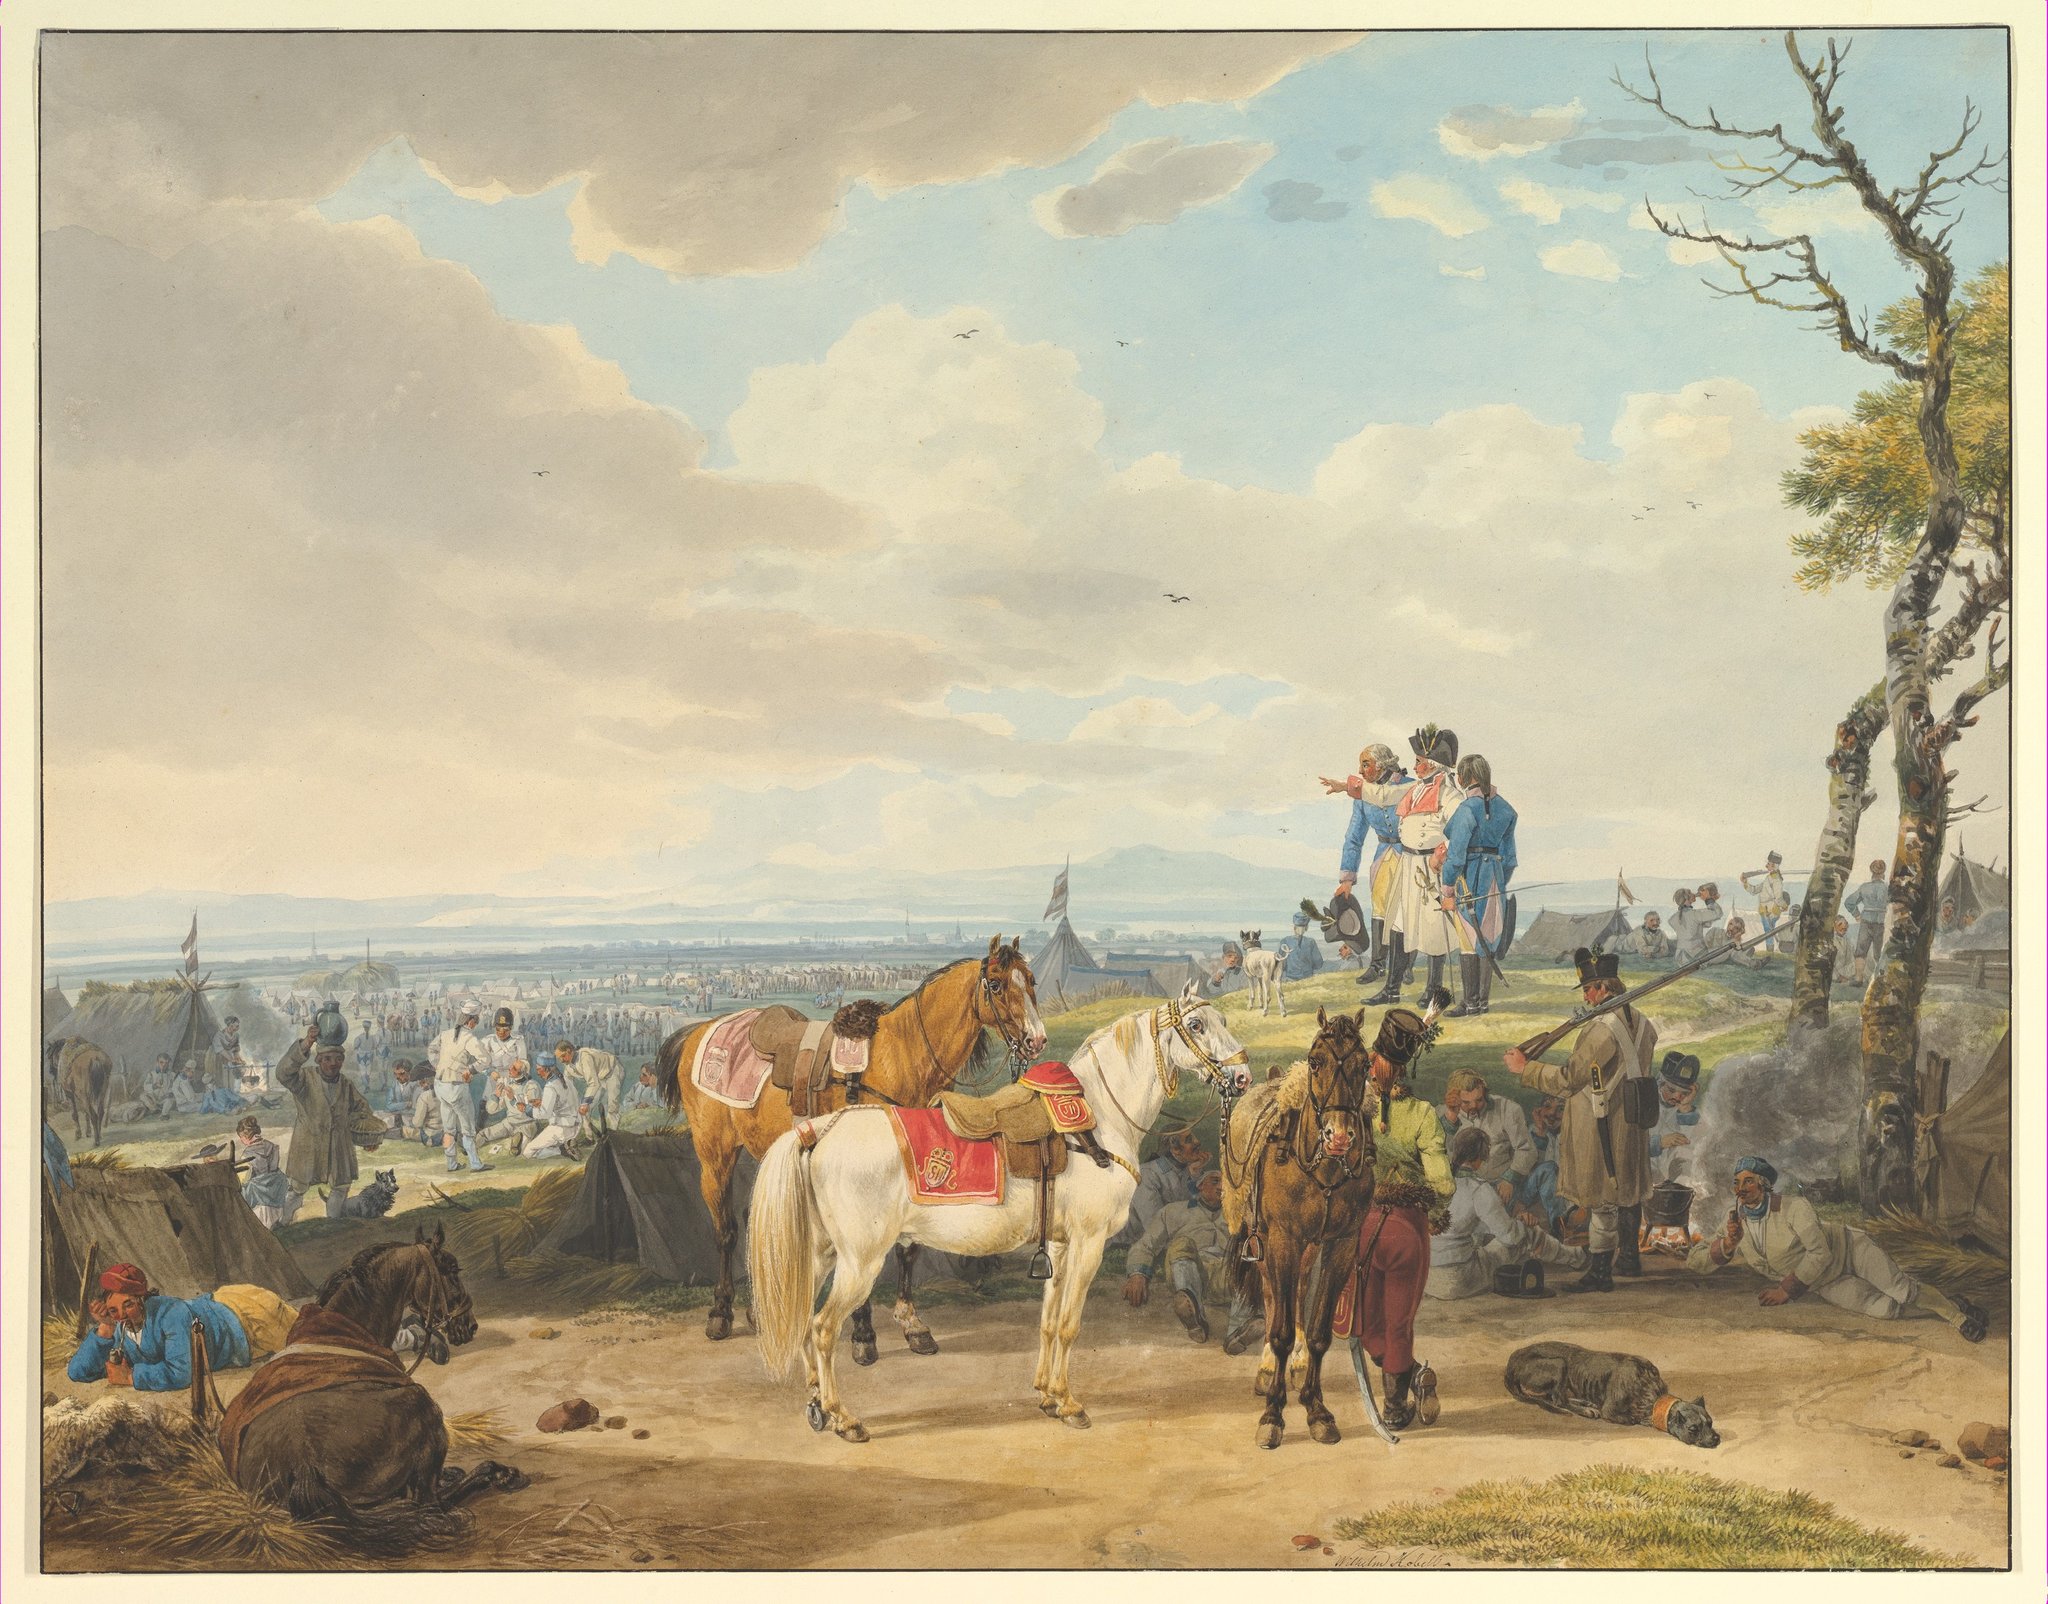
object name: drawing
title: Austrian Soldiers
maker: wilhelm von kobell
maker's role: artist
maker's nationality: german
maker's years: 1766-1853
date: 1767-1900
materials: graphite, ink, watercolor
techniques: pen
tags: human figures,soldiers,dogs,horses